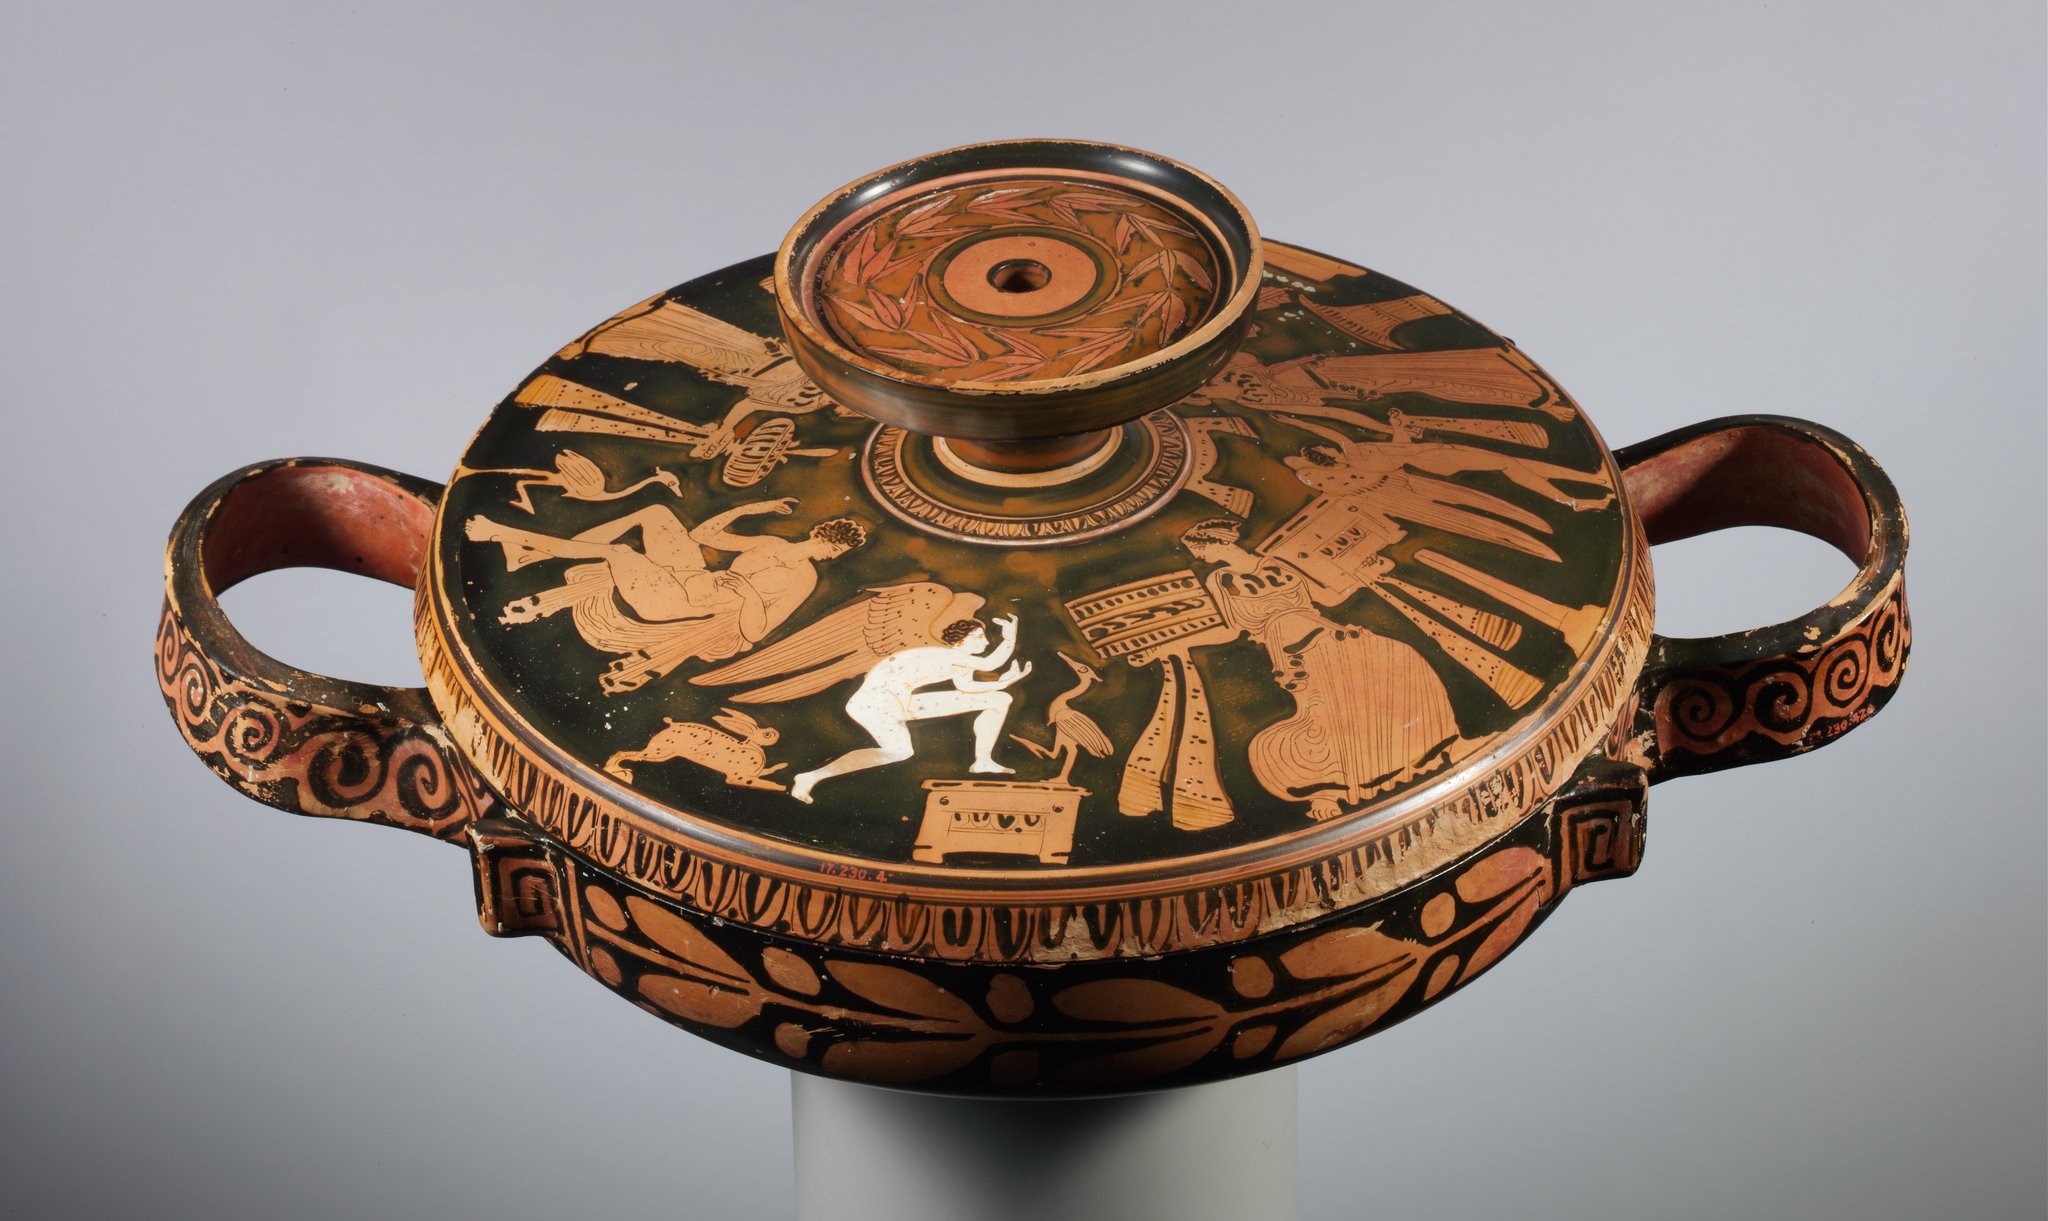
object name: lekanis with lid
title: Terracotta lekanis (covered dish)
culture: greek, attic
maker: otchët group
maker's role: artist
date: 400 BCE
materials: terracotta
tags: birds,women,eros,rabbits